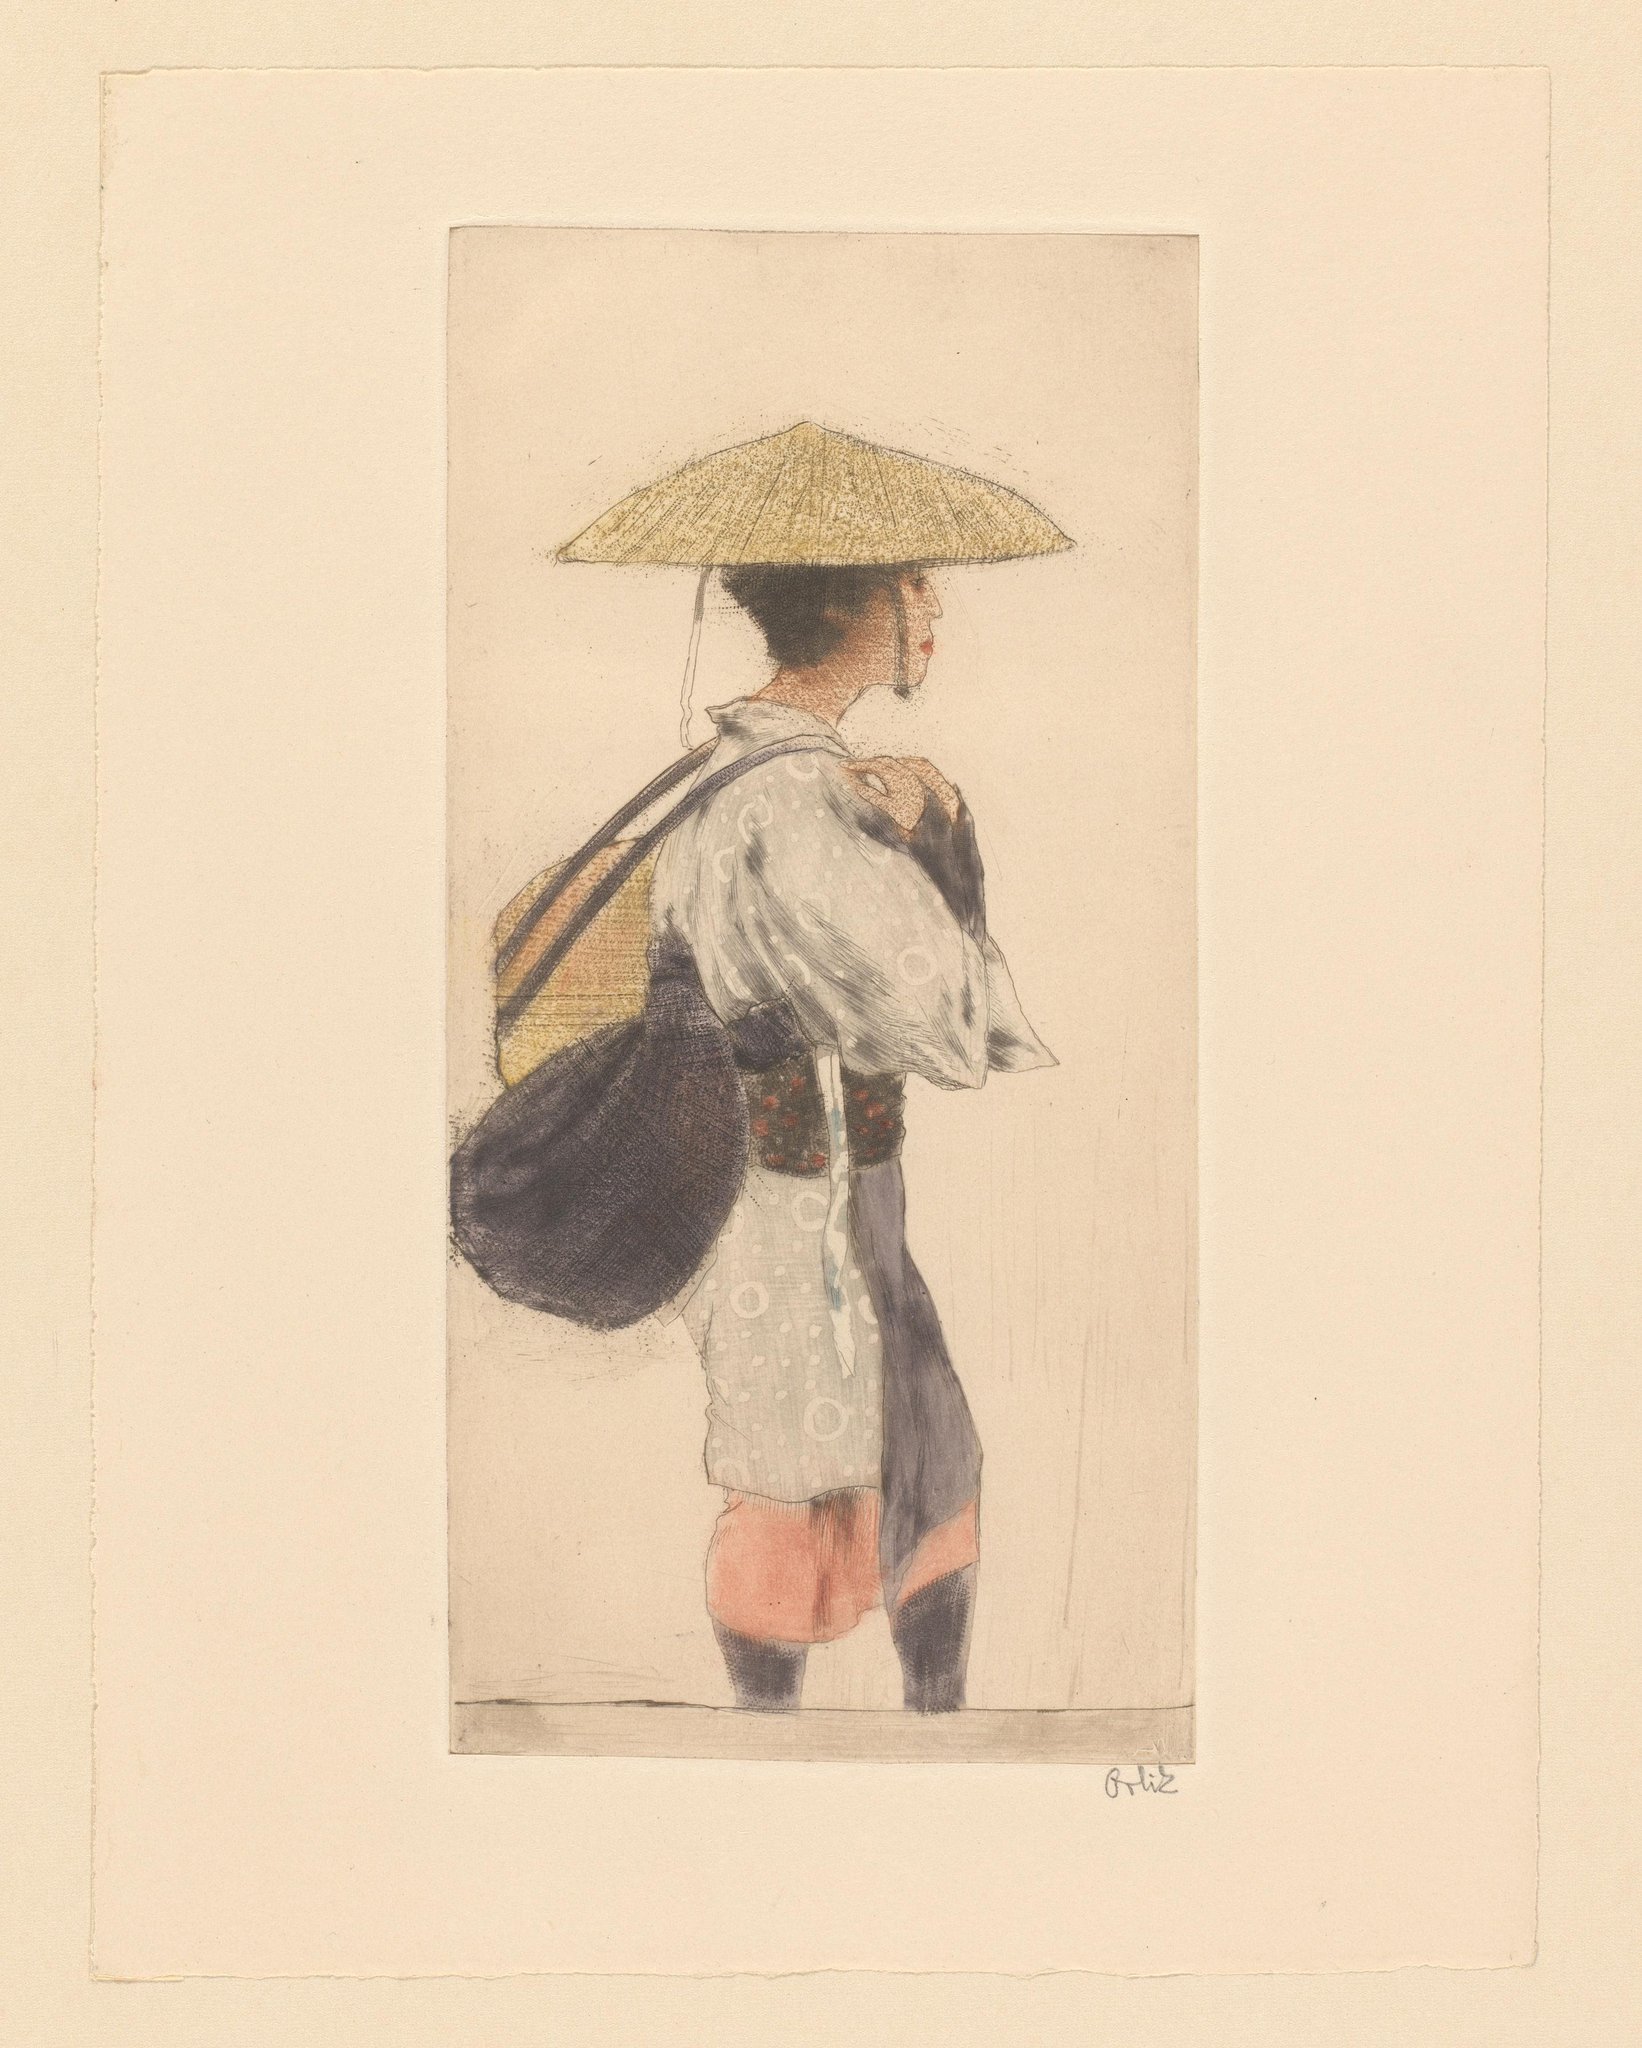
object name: print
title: Bauerin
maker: emil orlik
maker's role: painter, print maker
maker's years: 1870-1932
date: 1901-1903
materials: paper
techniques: aquatint, drypoint, roulette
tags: farmers - aa - female farmer, farmer's wife, carrying something on the head or on the shoulders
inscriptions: collector's mark: Lugt 2228